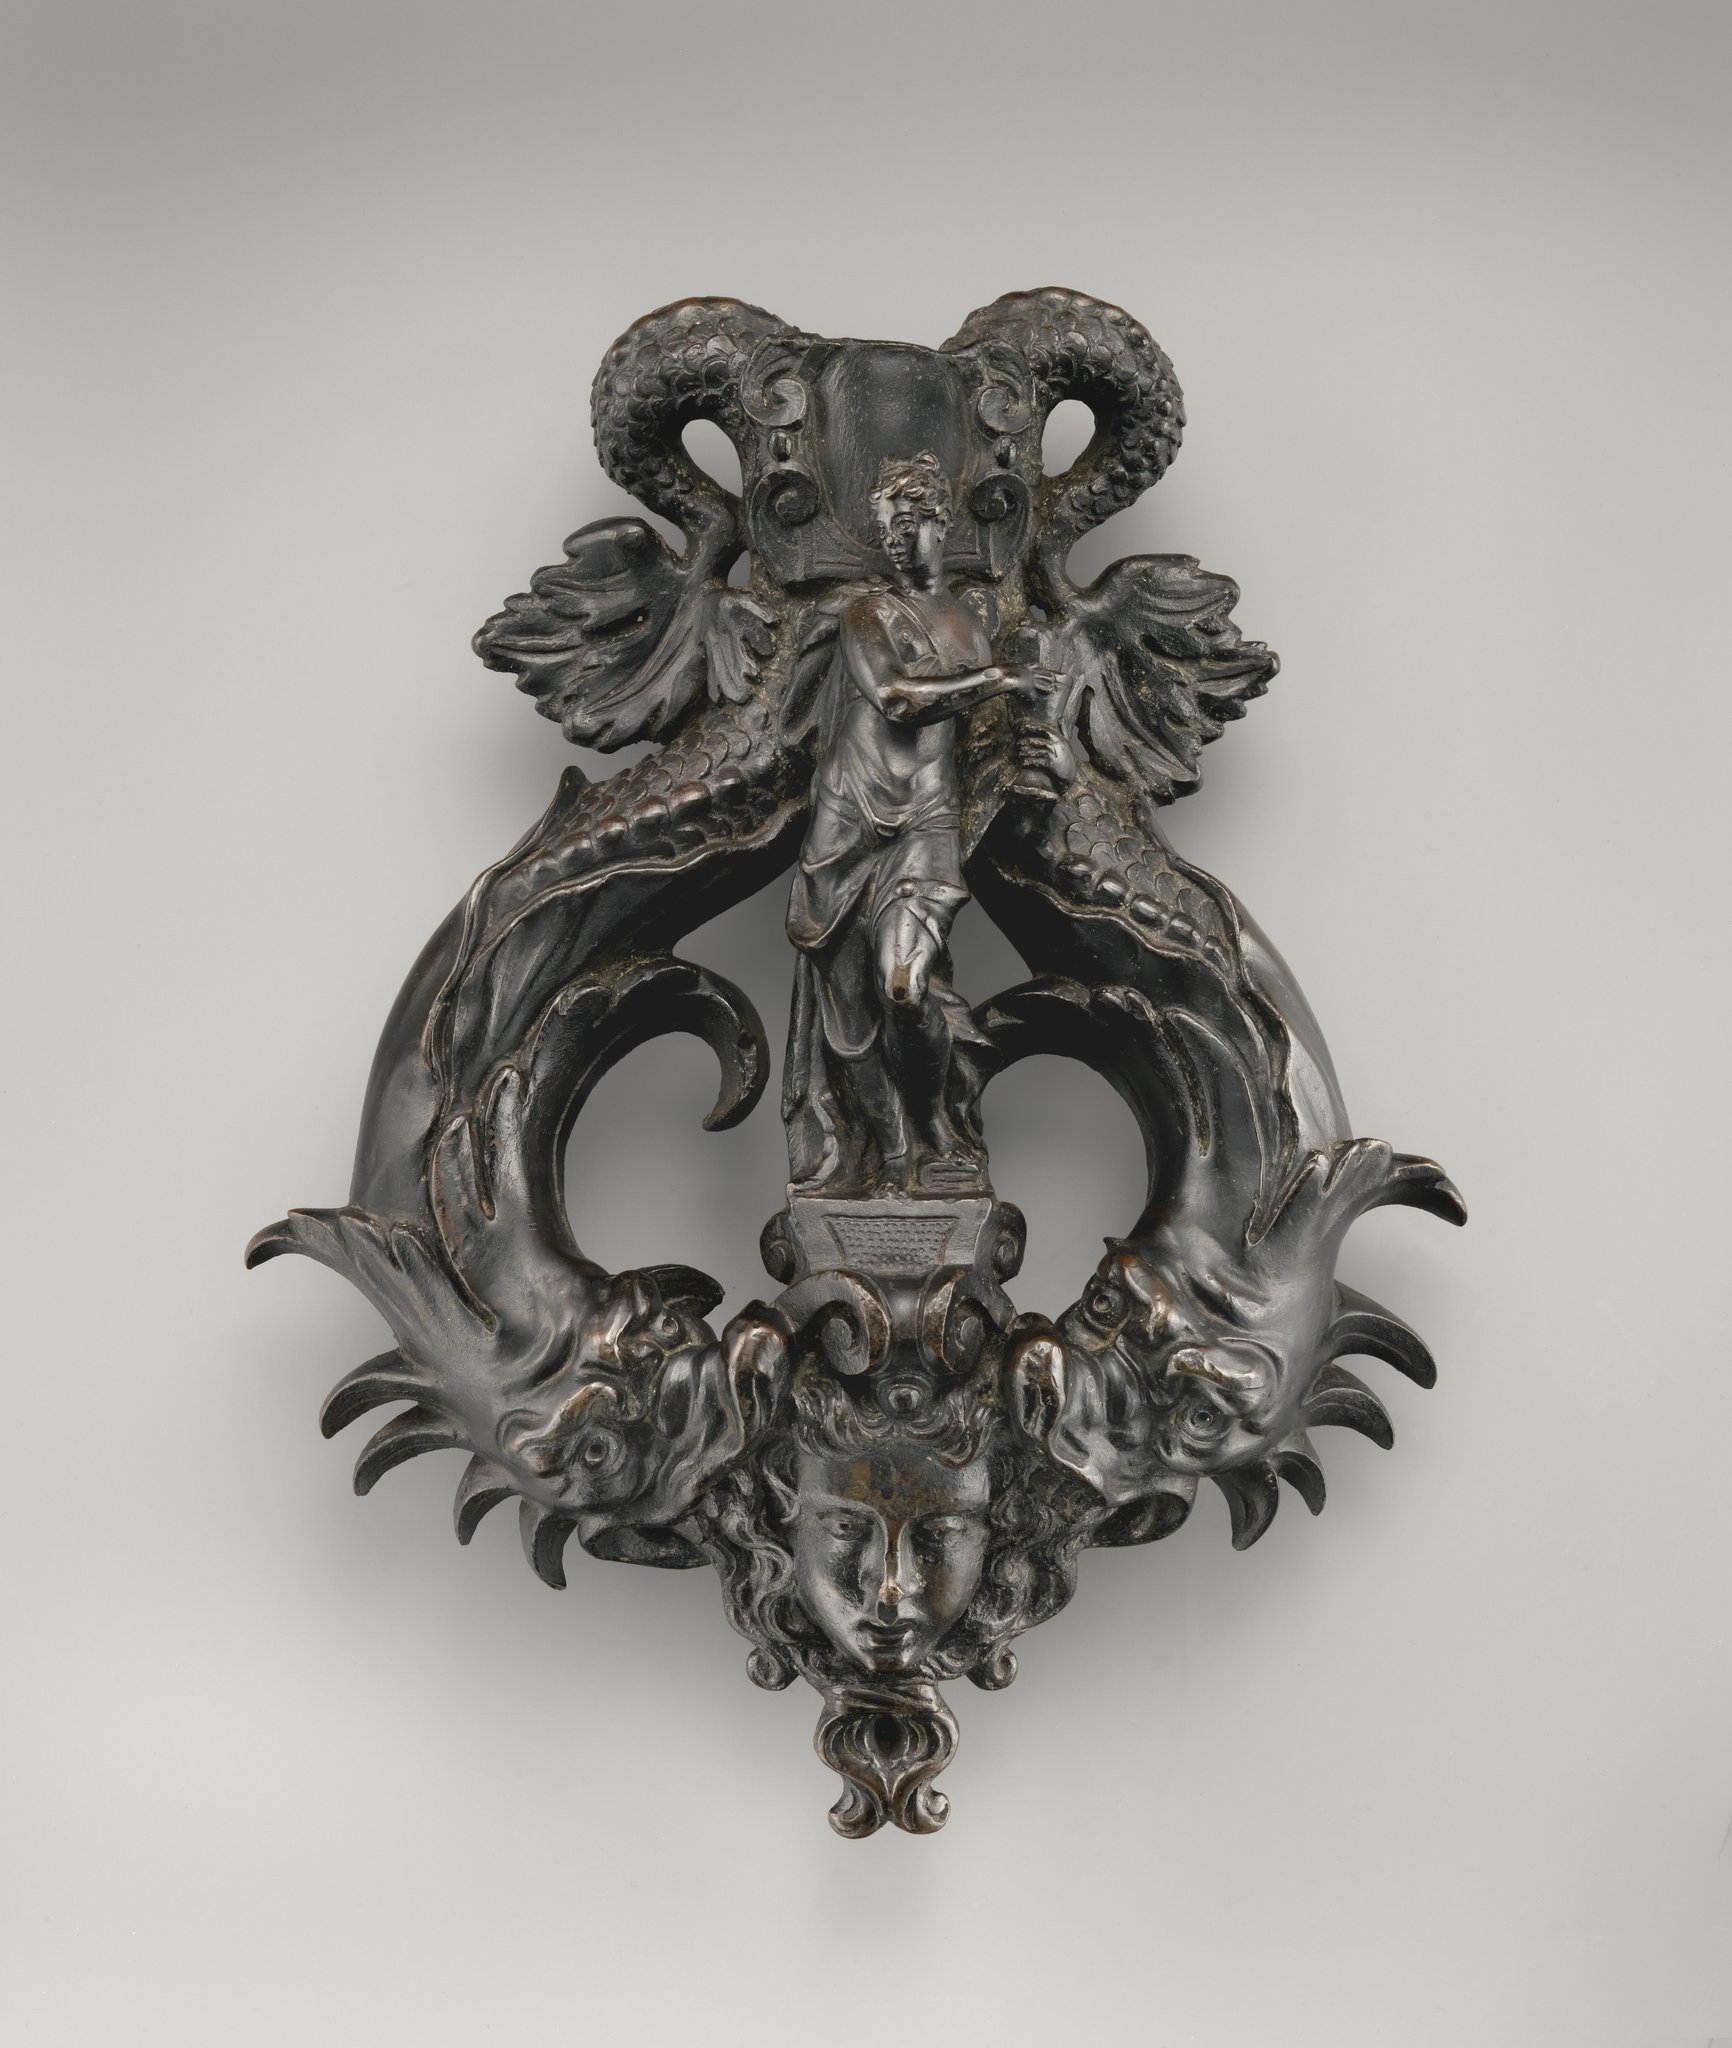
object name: door knocker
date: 1567-1600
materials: bronze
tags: human figures,faces